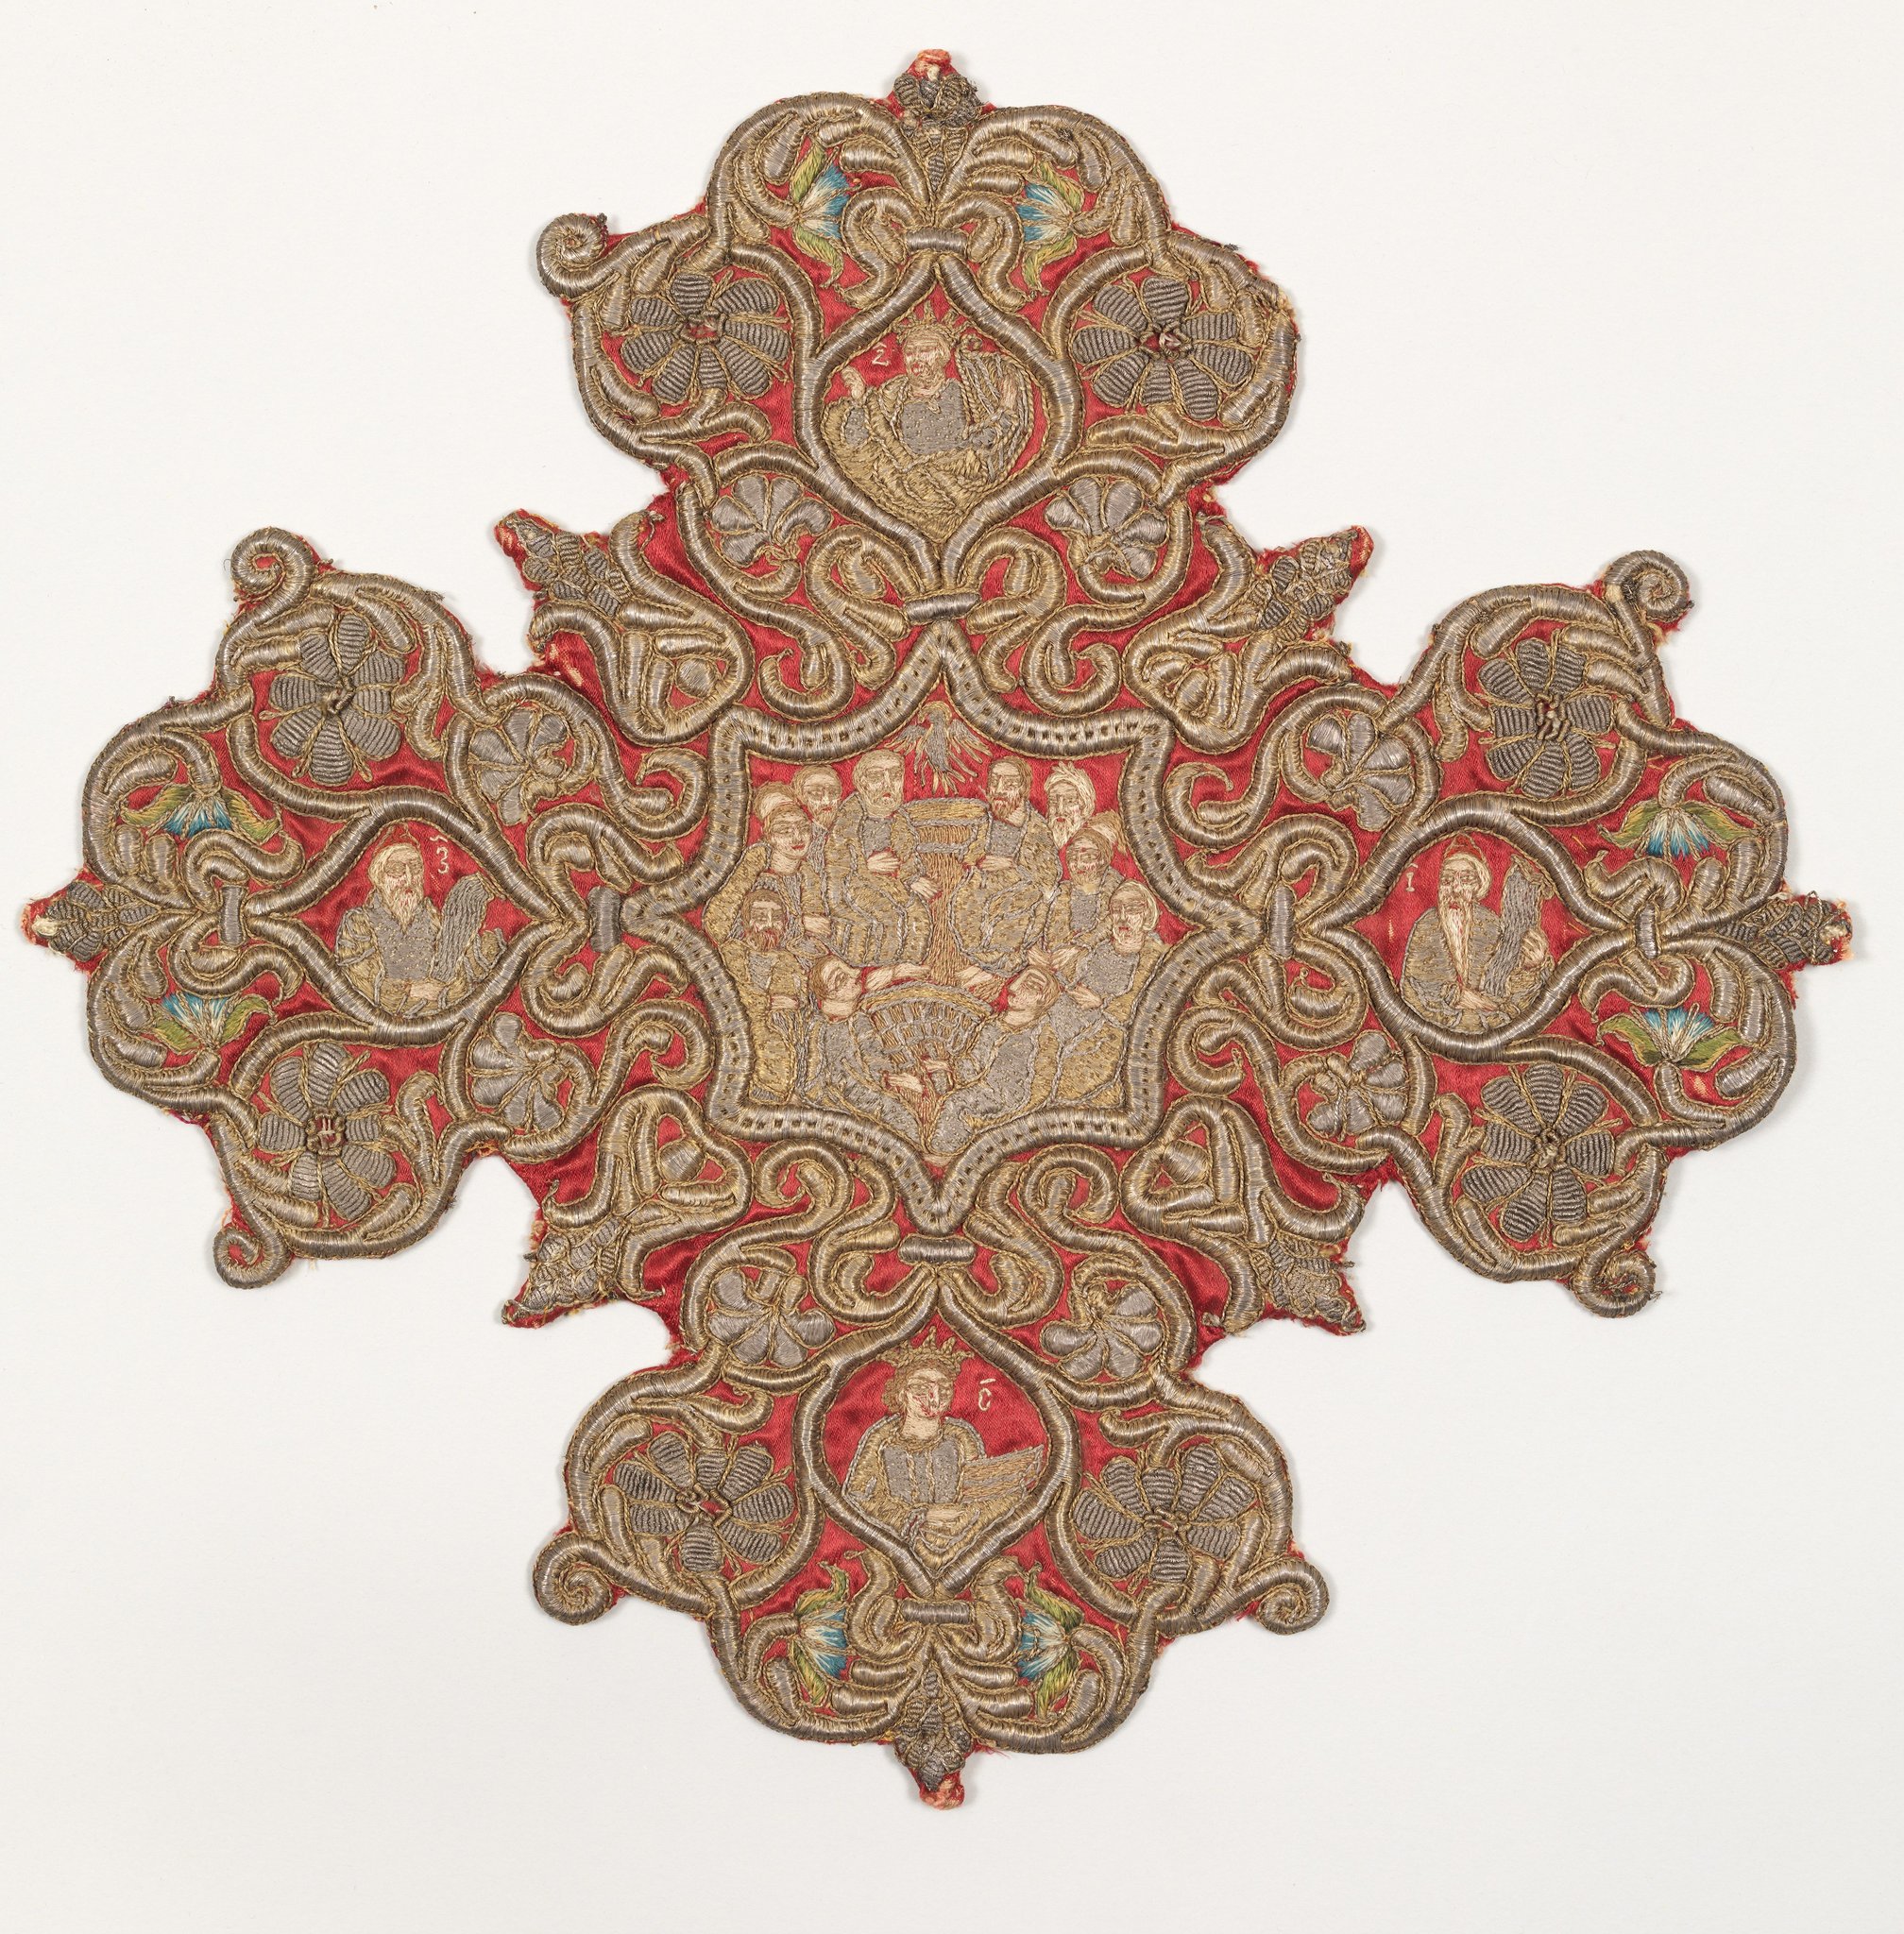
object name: embroidered cross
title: Embroidered cross from an Omophorion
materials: linen, metal thread, silk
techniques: backing, embroidery, weave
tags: men,women